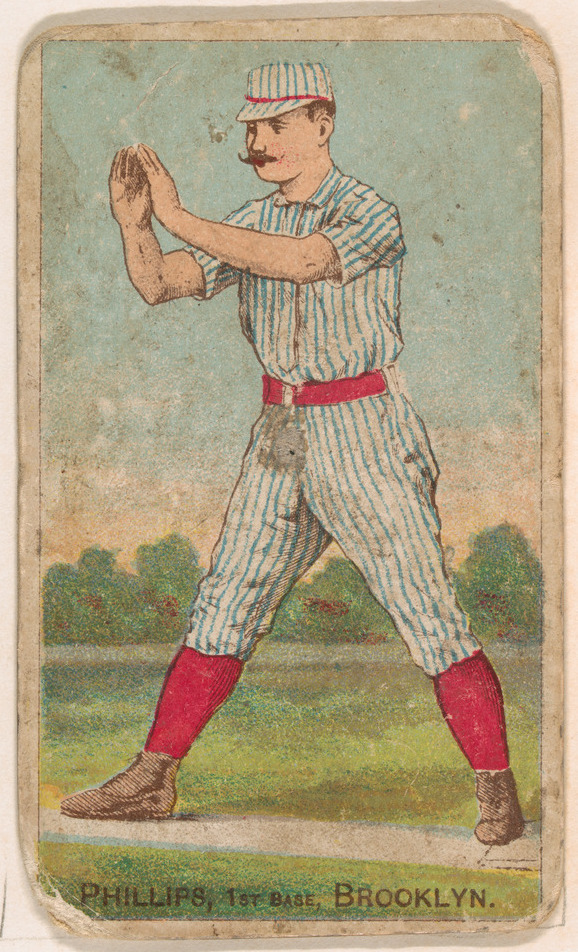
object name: baseball card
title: Phillips,1st Base, Brooklyn, from the Gold Coin series (N284) for Gold Coin Chewing Tobacco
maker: d. buchner & co., new york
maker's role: publisher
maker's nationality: american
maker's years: 1850-1900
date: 1887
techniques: color lithograph, drawing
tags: men,baseball,athletes